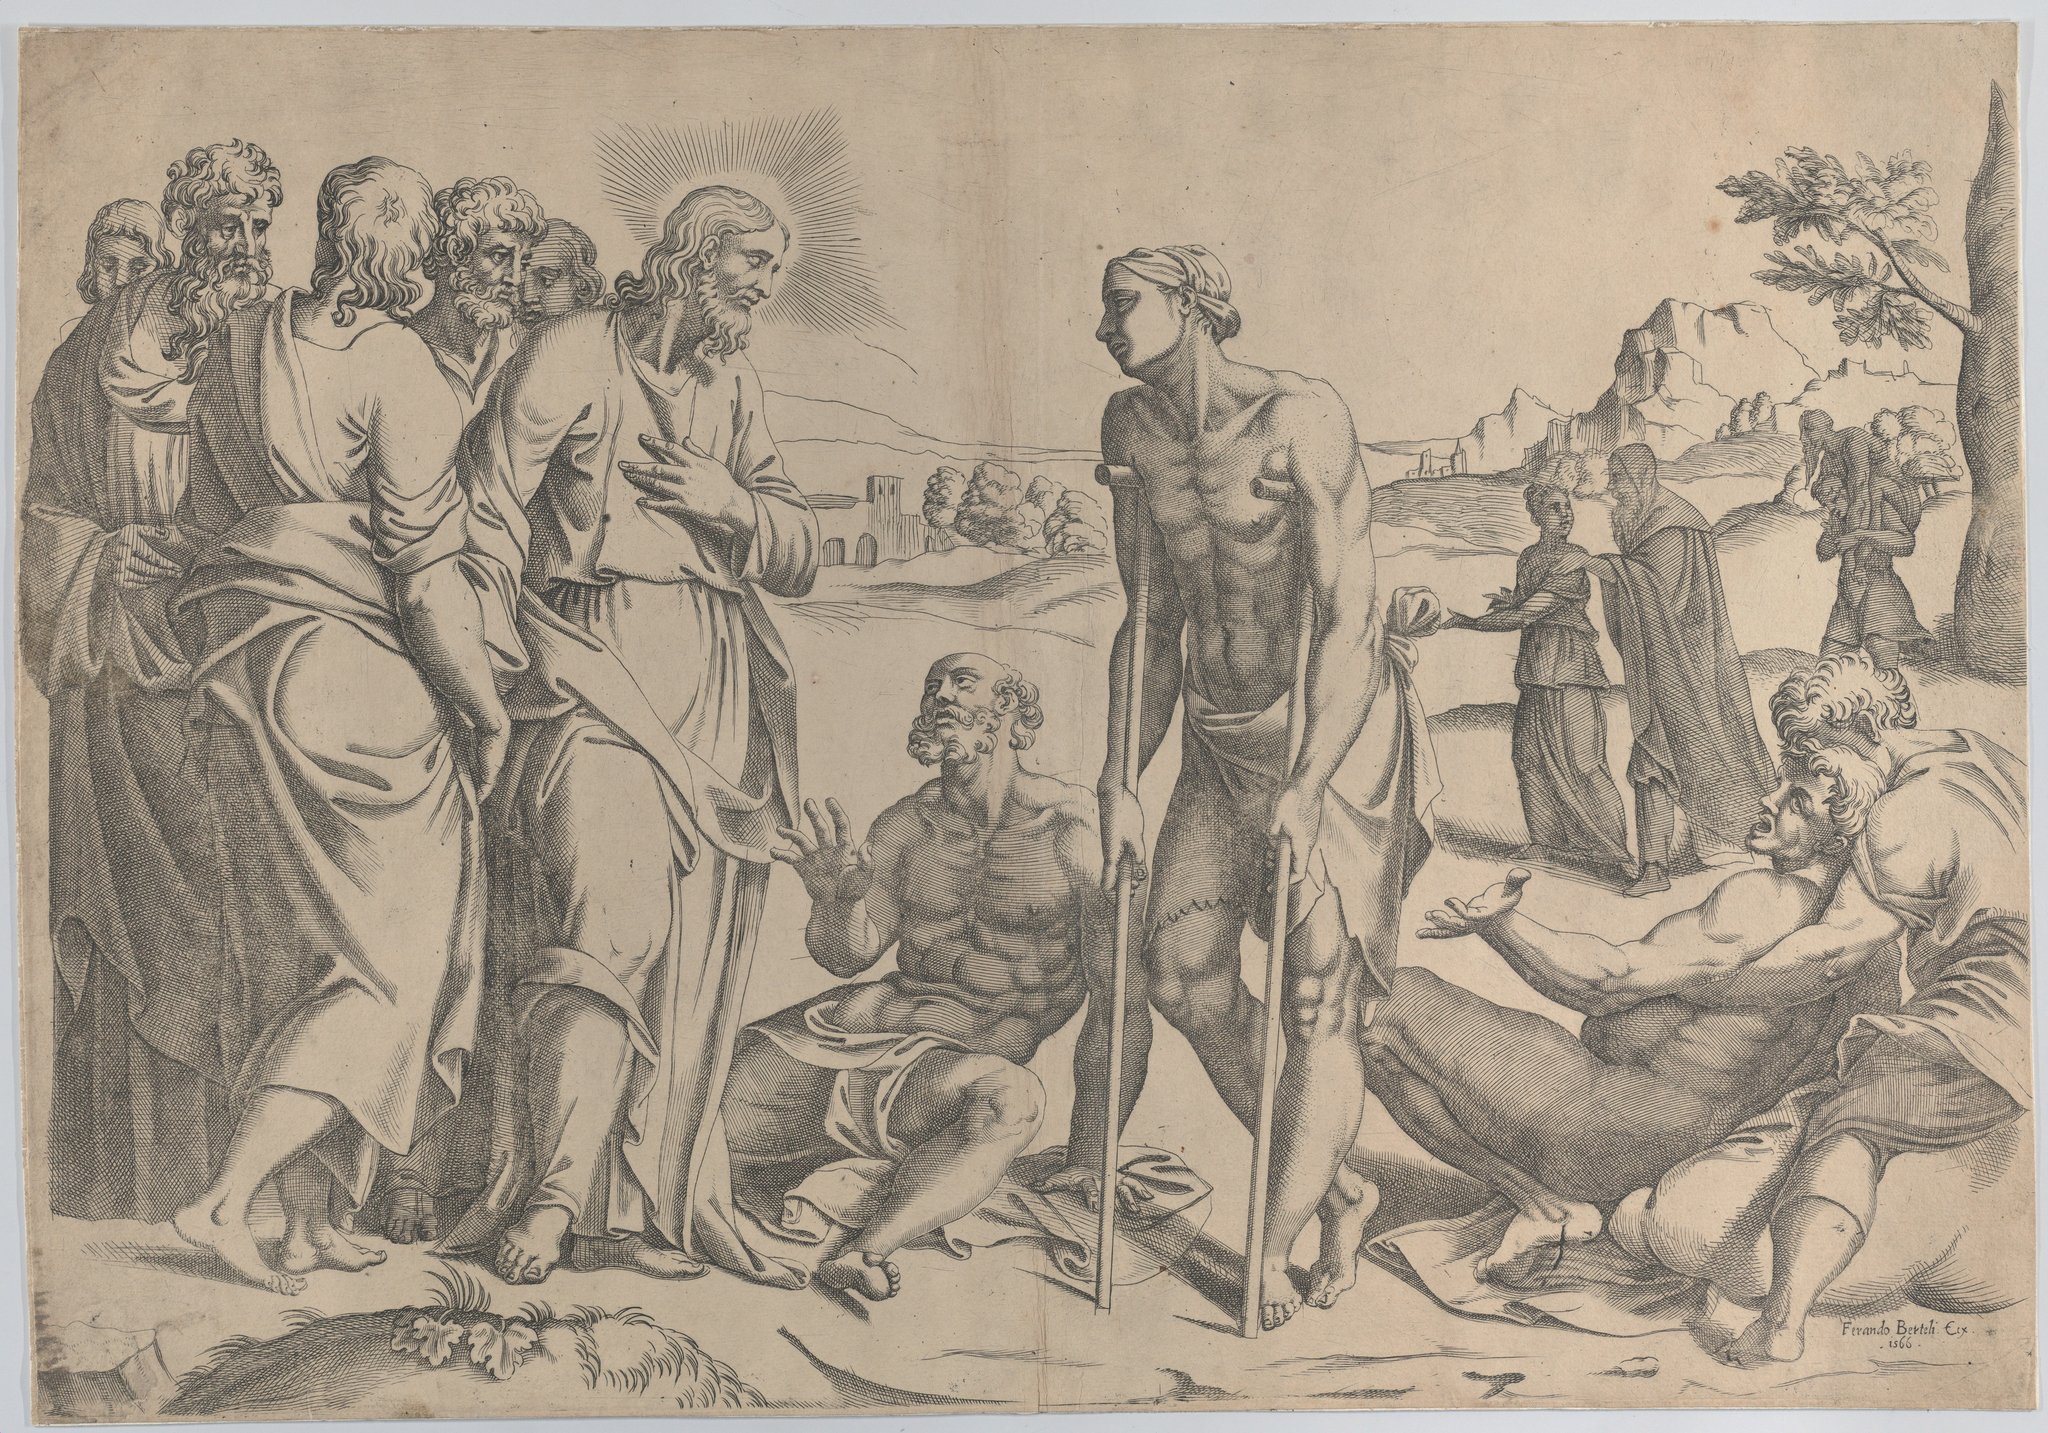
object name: print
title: Christ healing the sick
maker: Anonymous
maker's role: artist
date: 1566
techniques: engraving